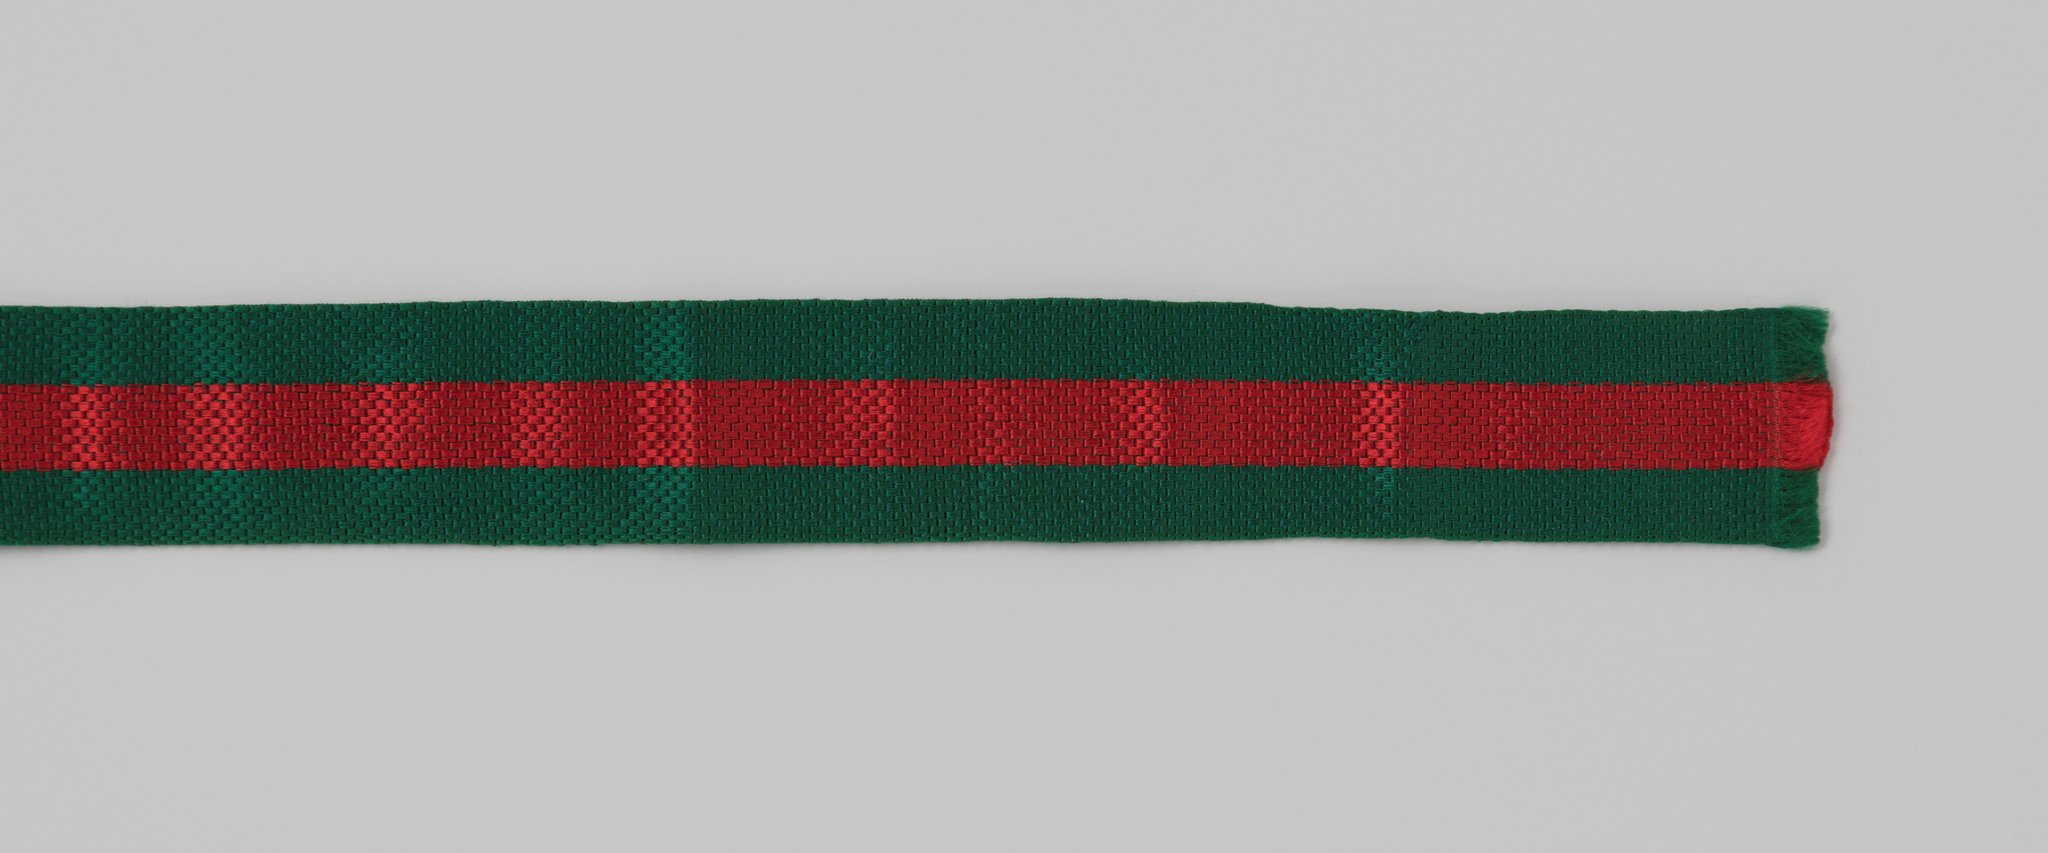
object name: clothing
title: Lint van kunstvezel, groen met rode middenbaan; rondgeweven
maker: Anonymous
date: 1400-1950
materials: fiber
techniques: weave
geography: western europe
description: Lint van kunstvezel, groen met rode middenbaan. Het lint is rondgeweven.